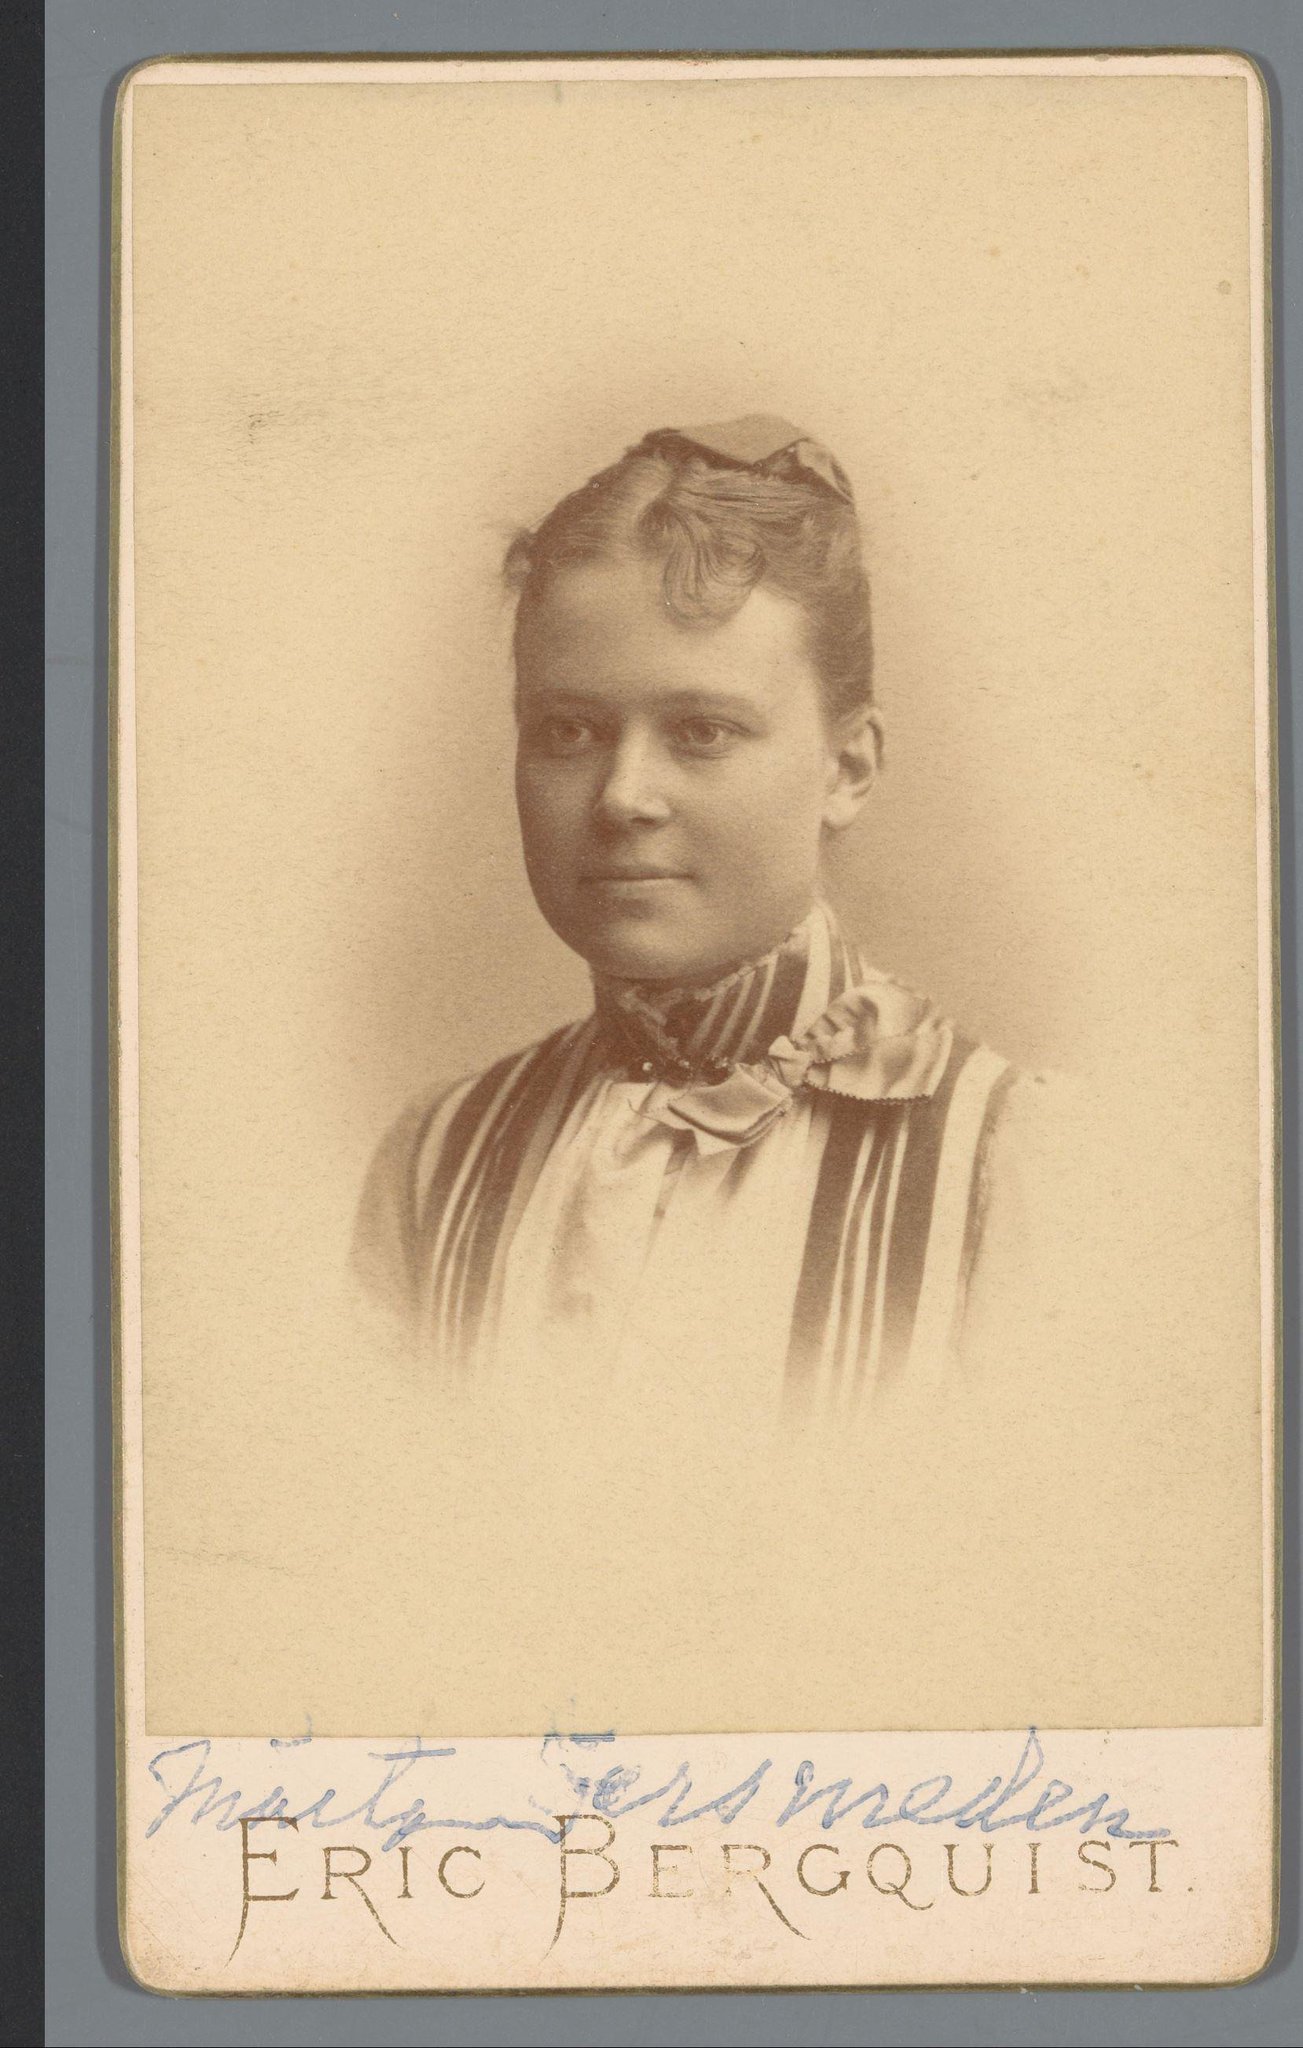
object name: carte de visite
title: Portret van een jonge vrouw, aangeduid als Mäitgen Tersmeden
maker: eric bergquist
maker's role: fotograaf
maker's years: 1855-1906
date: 1881-1895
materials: cardboard, paper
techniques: albumen print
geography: orebro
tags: adult woman, historical persons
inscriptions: inscription: ‘Plåten förvaras för efterbeställning./ NERLIEN’, address: ‘ÖREBRO,/ Köpmangatan No 21.’